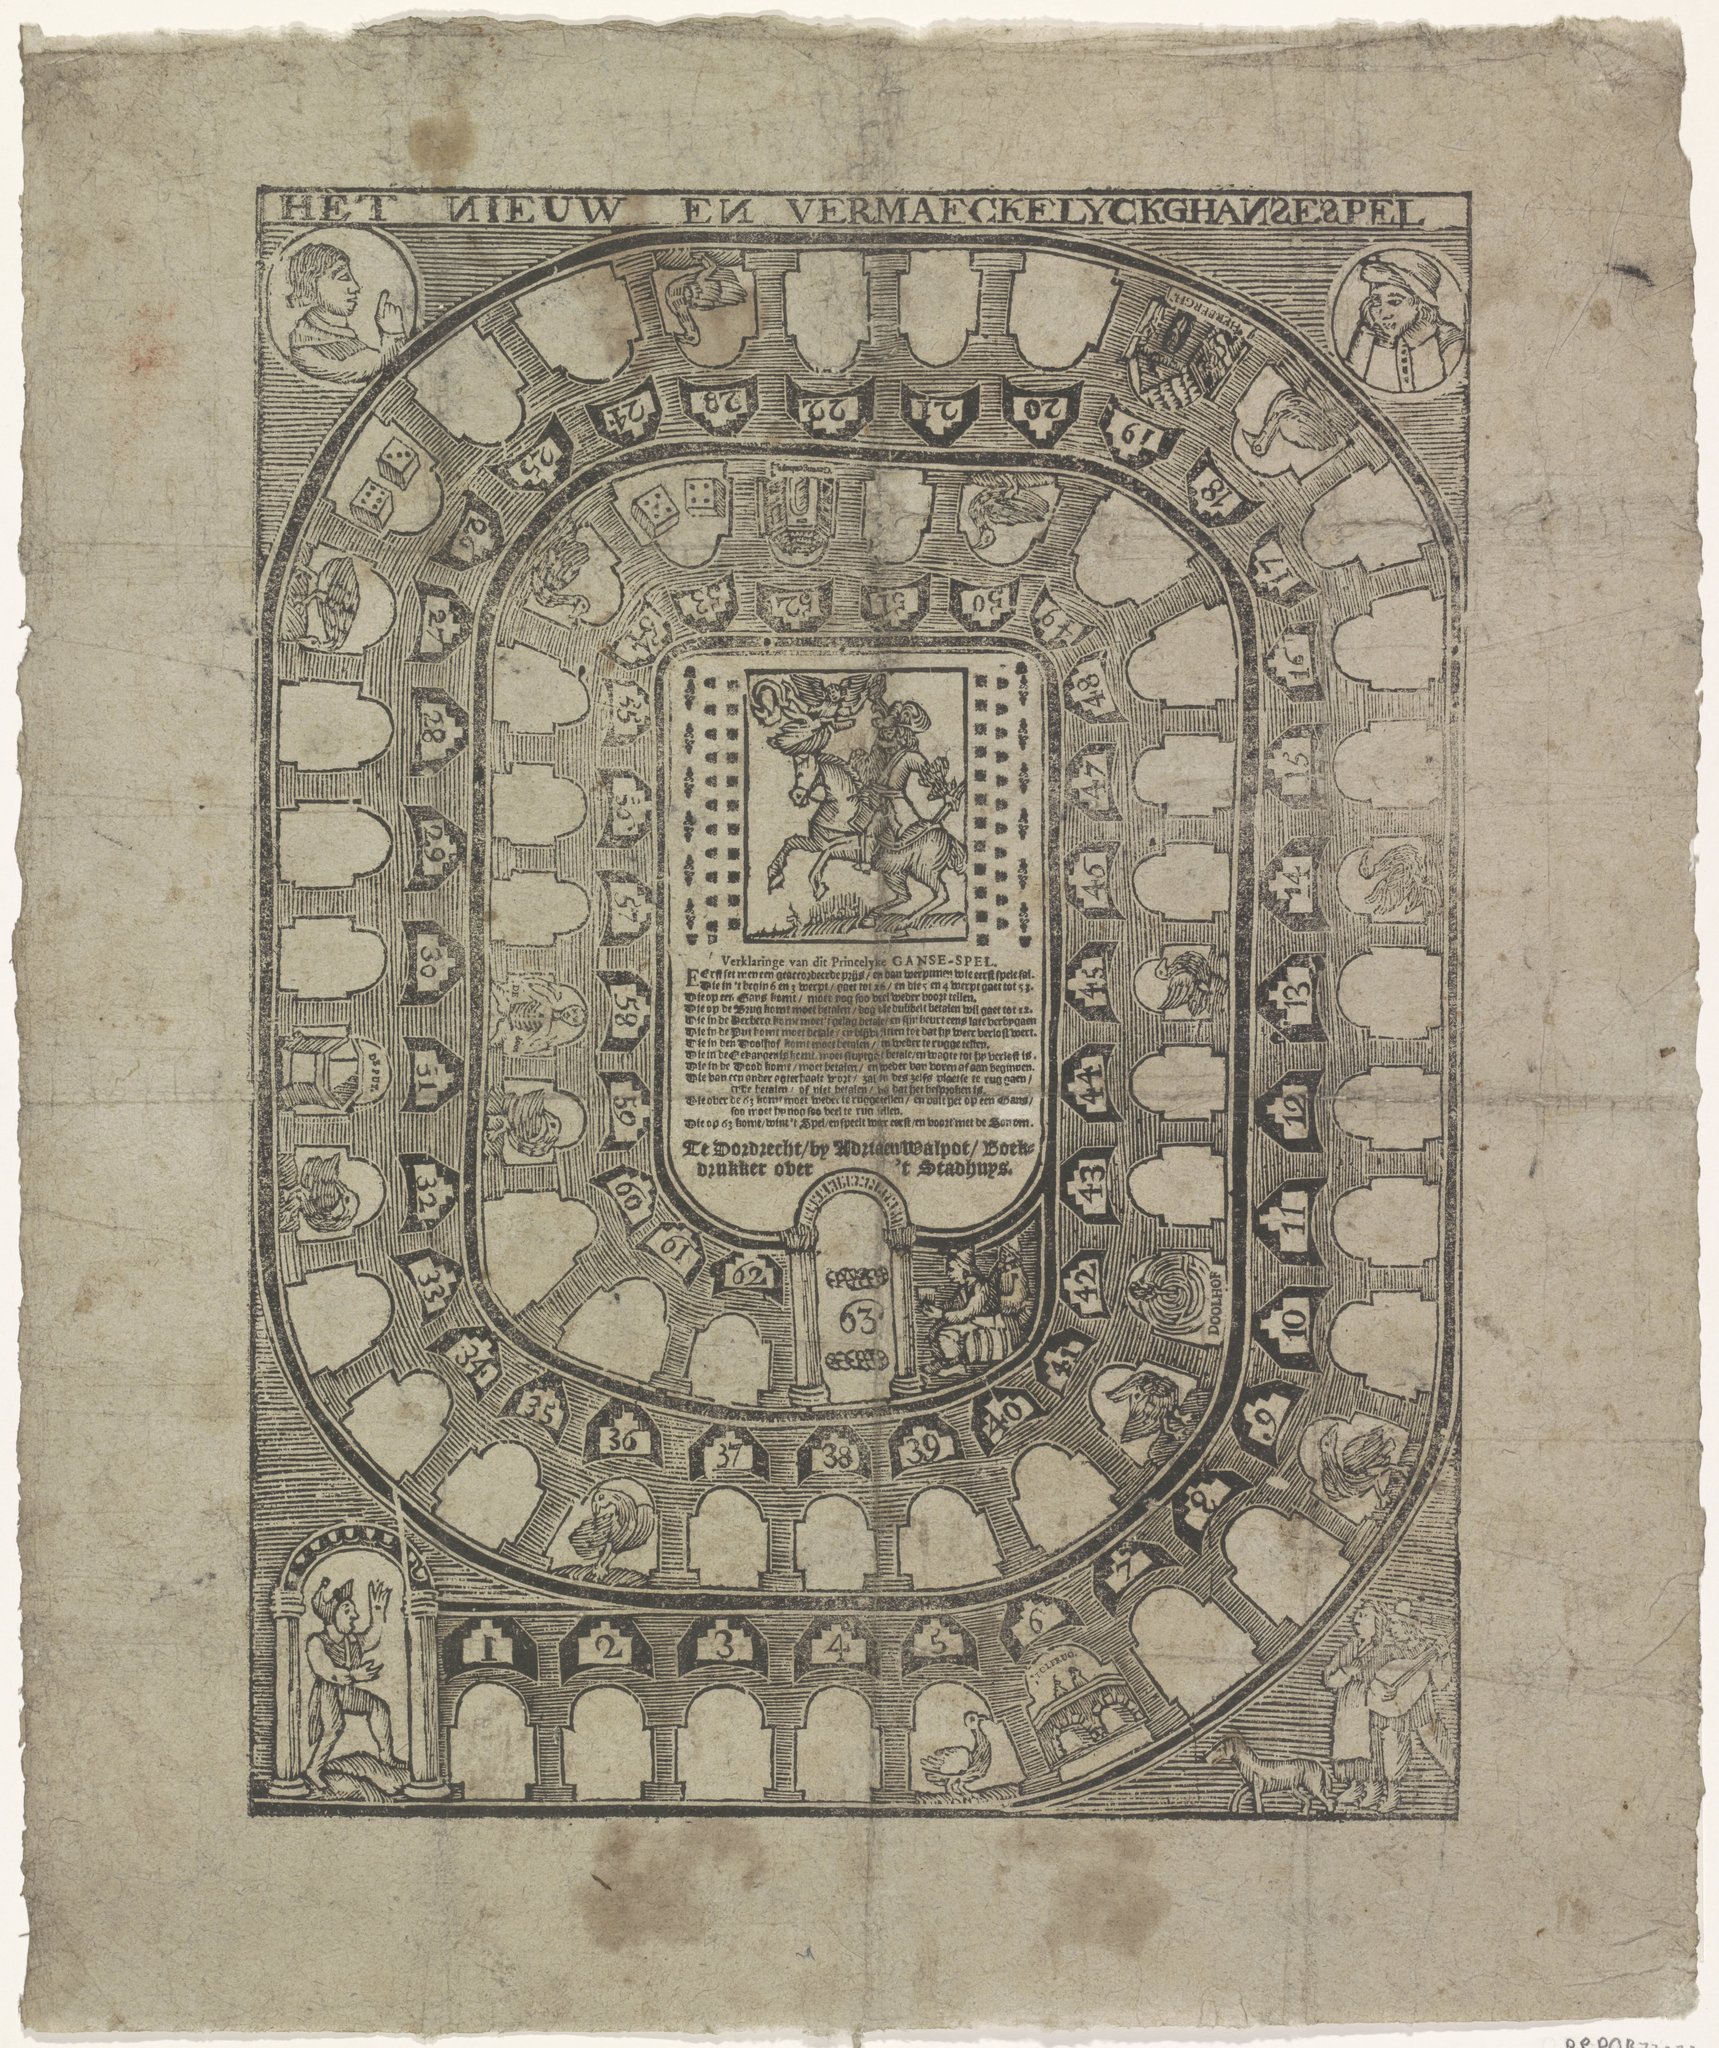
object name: popular print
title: Het nieuw en vermaeckelyck ghansespel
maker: adriaan walpot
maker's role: publisher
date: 1760-1793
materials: paper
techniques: woodcut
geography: dordrecht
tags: the hague, william iii (prince of orange and king of england, scotland, and ireland), goose-game, board-games of chance, victory, board-games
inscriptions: collector's mark: Lugt 2228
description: Ganzenbordspel met vakjes genummerd van 1 tot en met 63. In enkele vakjes voorstellingen van ganzen. In het grote centrale vak de spelregels en stadhouder Willem III te paard met boven hem de gevleugelde overwinning. Titel in de bovenmarge.